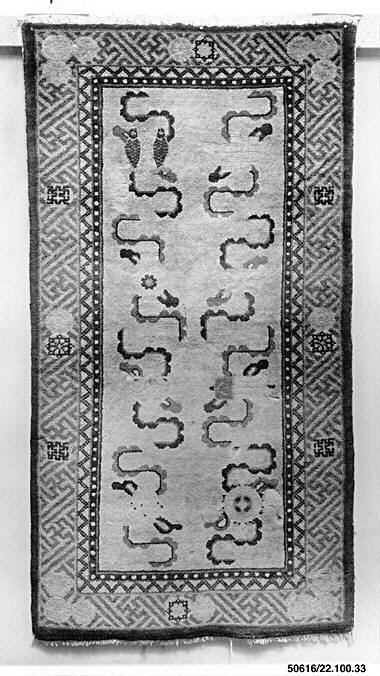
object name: kang rug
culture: chinese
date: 1801-1900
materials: cotton, wool